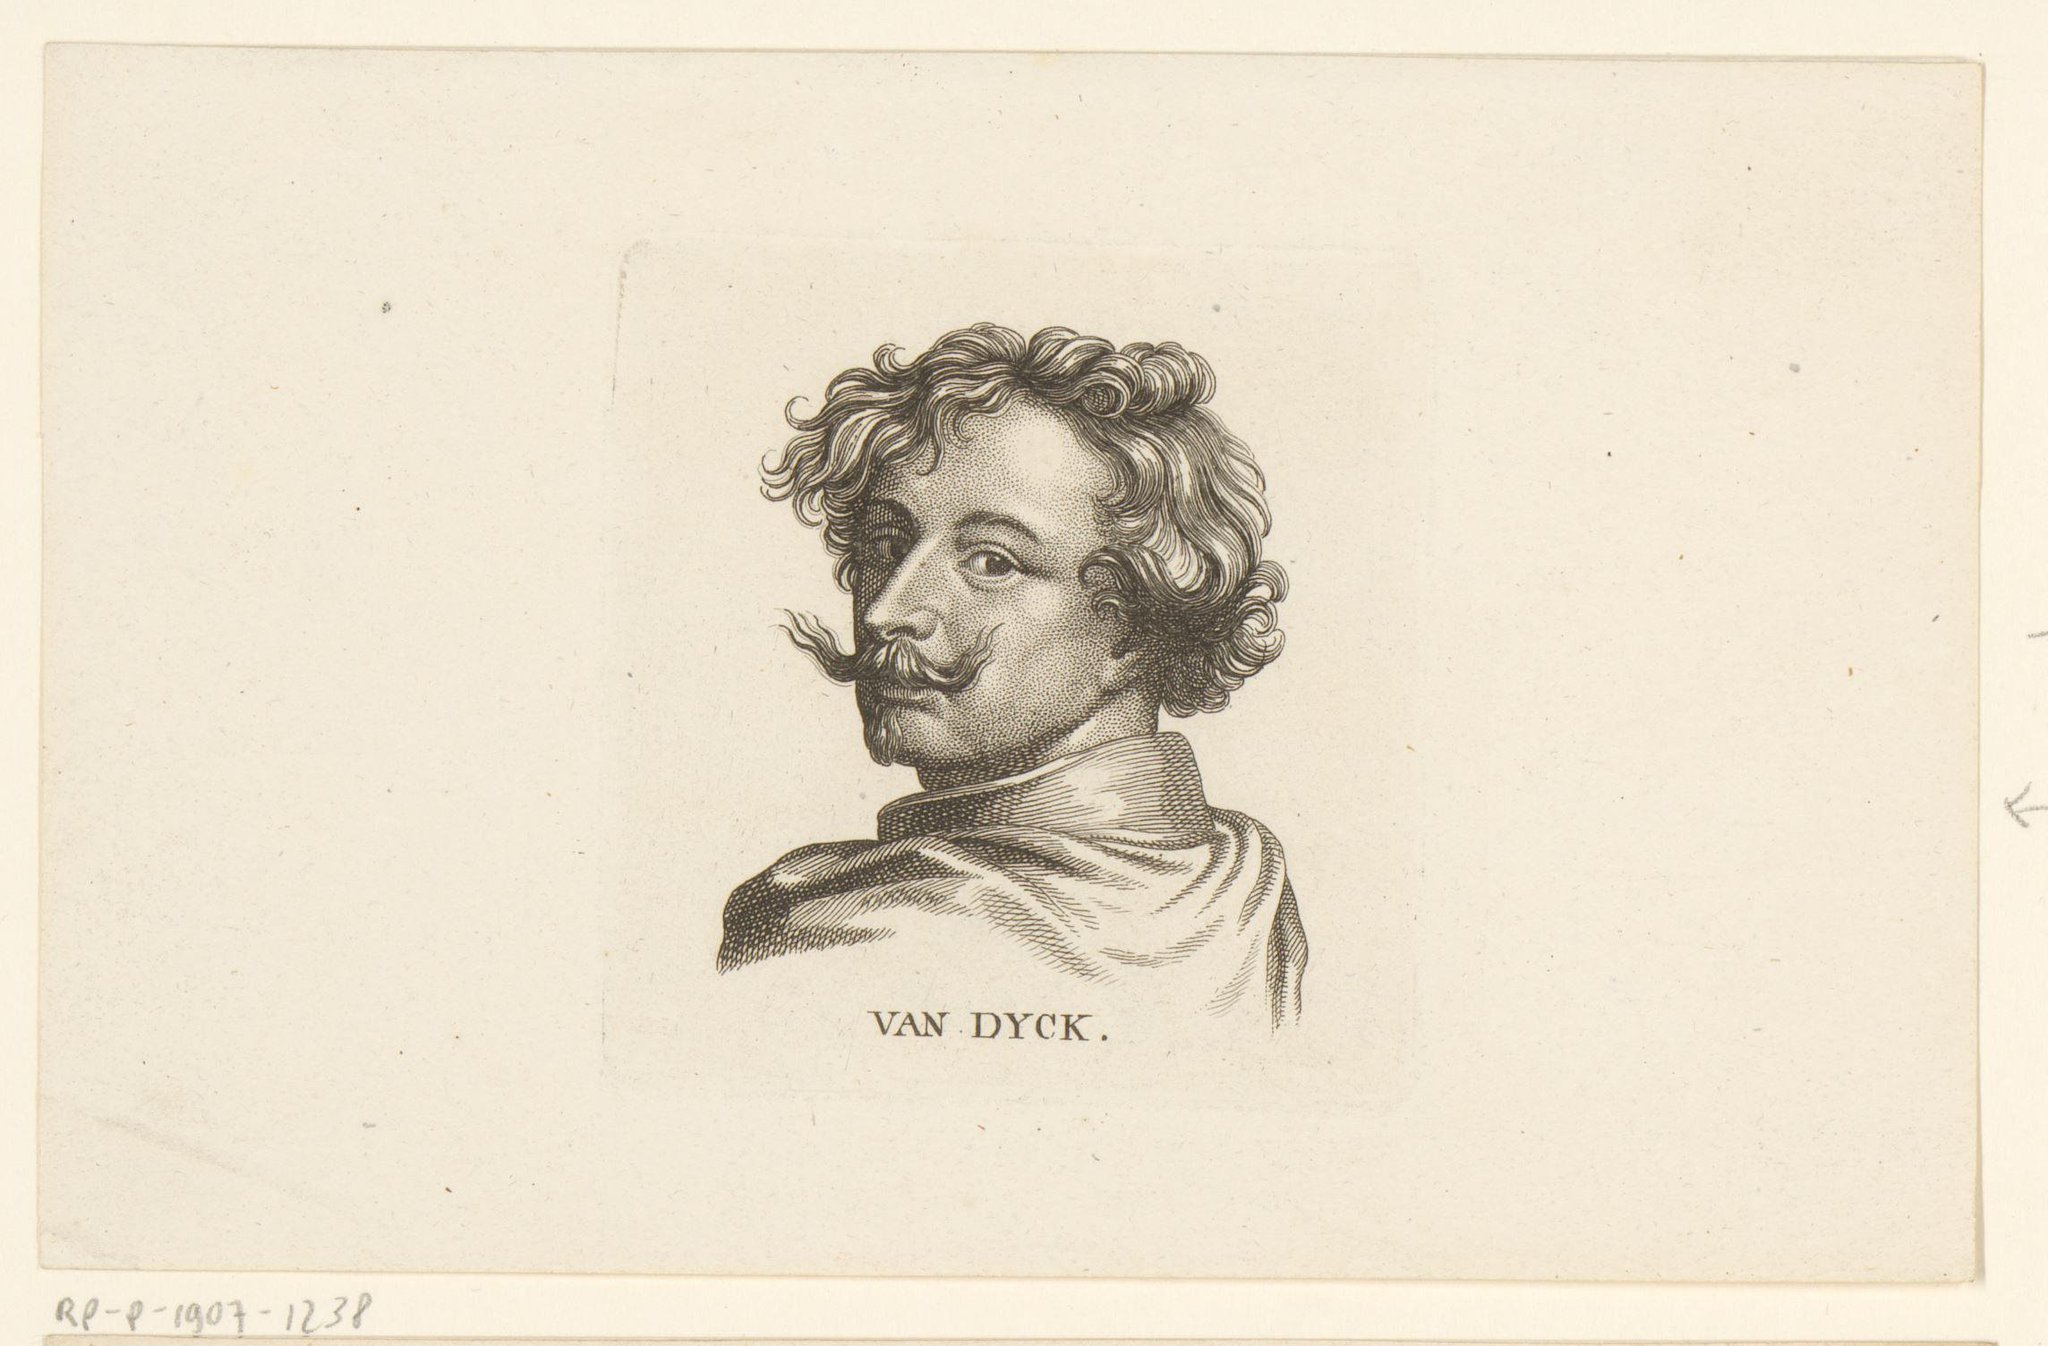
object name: print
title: Portret van Anthony van Dyck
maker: ernst ludwig riepenhausen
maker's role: print maker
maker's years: 1765-1840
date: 1775-1840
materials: paper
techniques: etching, engraving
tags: antwerp, london, painter, print maker, draughtsman, anthony van dyck, historical persons, portrait, self-portrait of painter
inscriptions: collector's mark: Lugt 2228